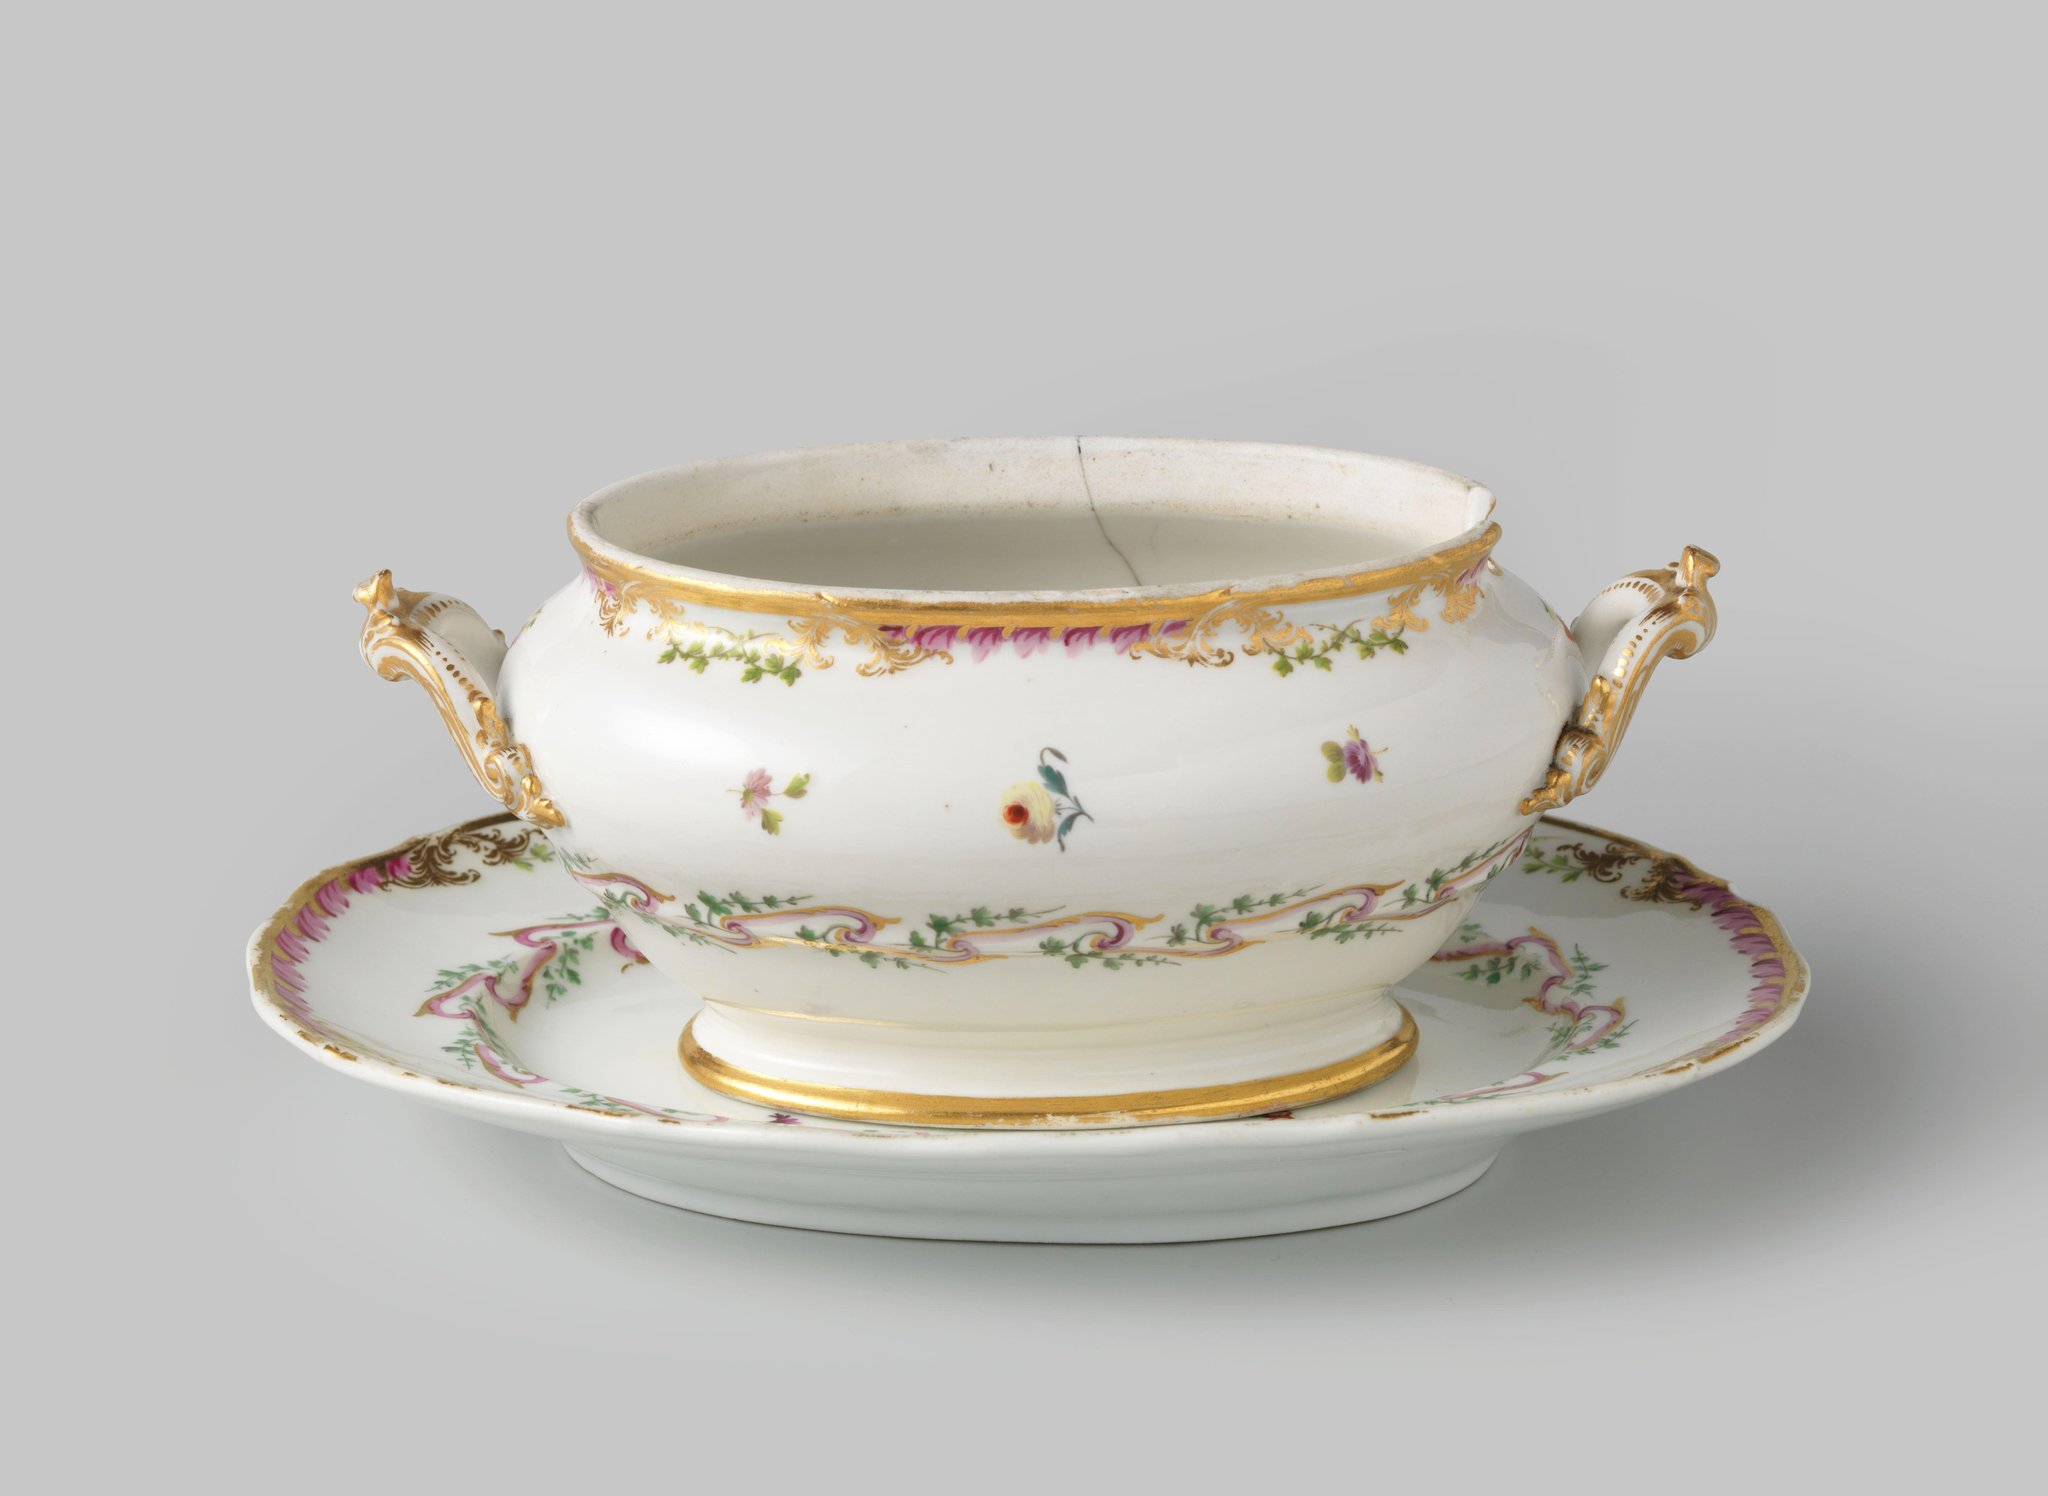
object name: tureen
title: Sauskom, behorend bij een servies met geslingerd lintmotief met bladertakken, bloemboeketten en gestrooide bloemtakken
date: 1780-1820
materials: porcelain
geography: amsterdam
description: Sauskom, oorspronkelijk twee, behorend bij een servies van porselein met geslingerd lintmotief in paars en goud met groene bladertakken, bloemboeketten en gestrooide bloemtakken. Randen lichtgegolfd met decoratie in goud met paars bladmotief waartussen groen gekruist bladmotief. Gemerkt: M.O.L. en Amstel. Opmerking: tweede onderschotel in 1948 afgestaan aan het Internationaal Museum voor Ceramiek te Faënza.